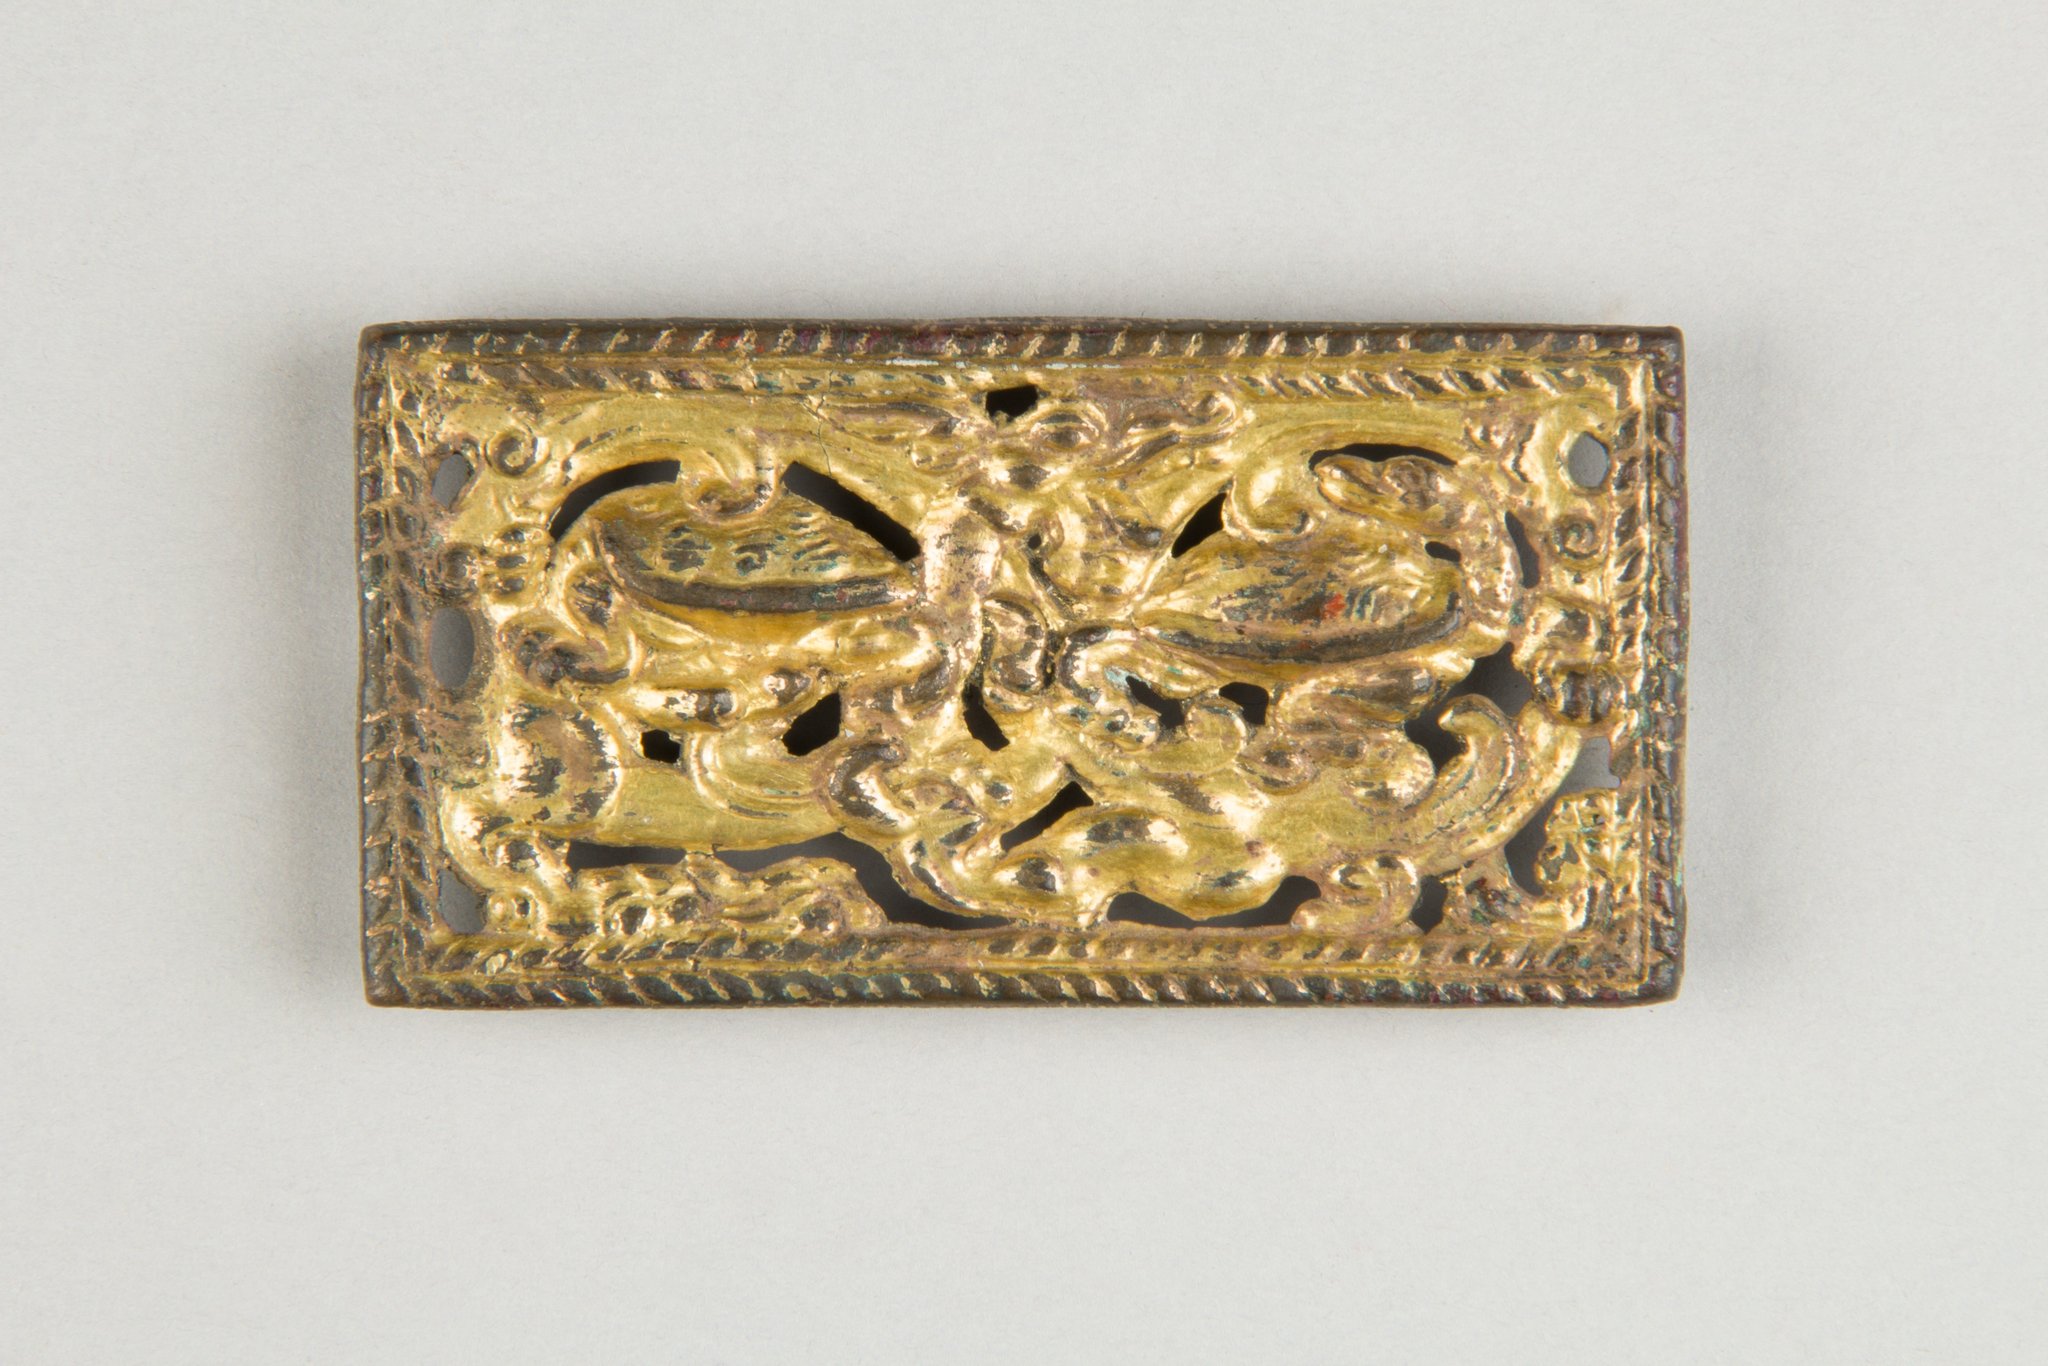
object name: belt plaque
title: Belt Plaque with Dragon and Tortoises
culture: northwest chinese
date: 200-1 BCE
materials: bronze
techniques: gilding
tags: dragons